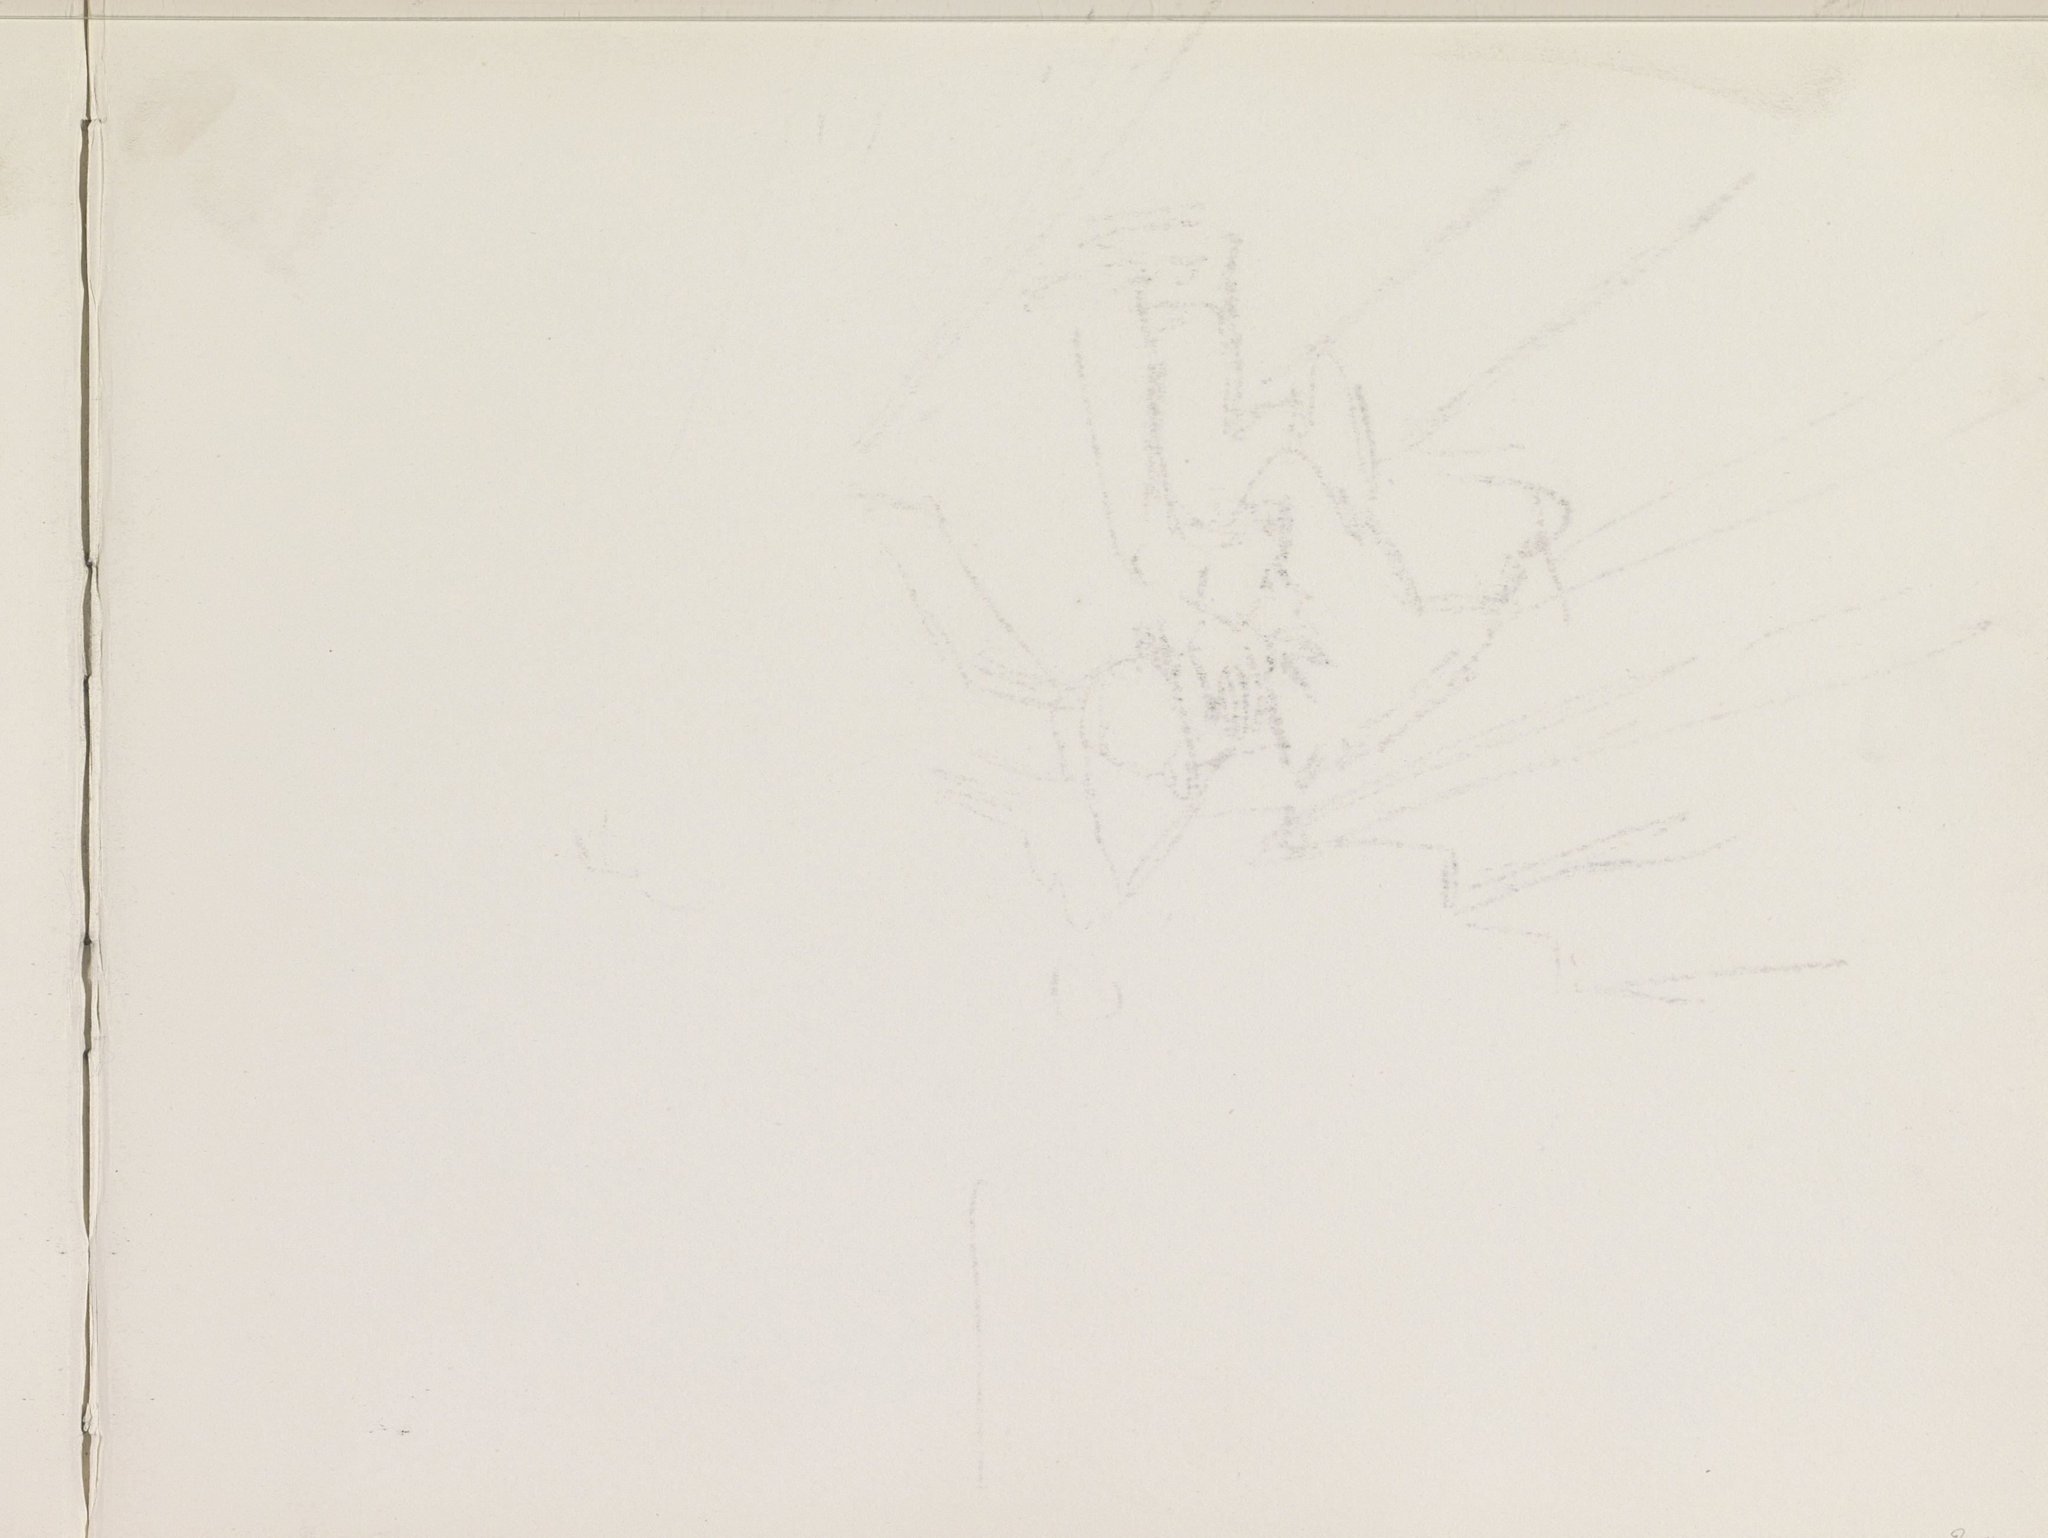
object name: sketchbook leaf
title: Abklatsch van de krijttekening op blad 19 verso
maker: isaac israels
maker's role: draughtsman, painter, print maker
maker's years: 1865-1934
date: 1875-1934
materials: paper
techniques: printmaking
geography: the hague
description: Blad 20 recto uit schetsboek VII met 26 bladen.